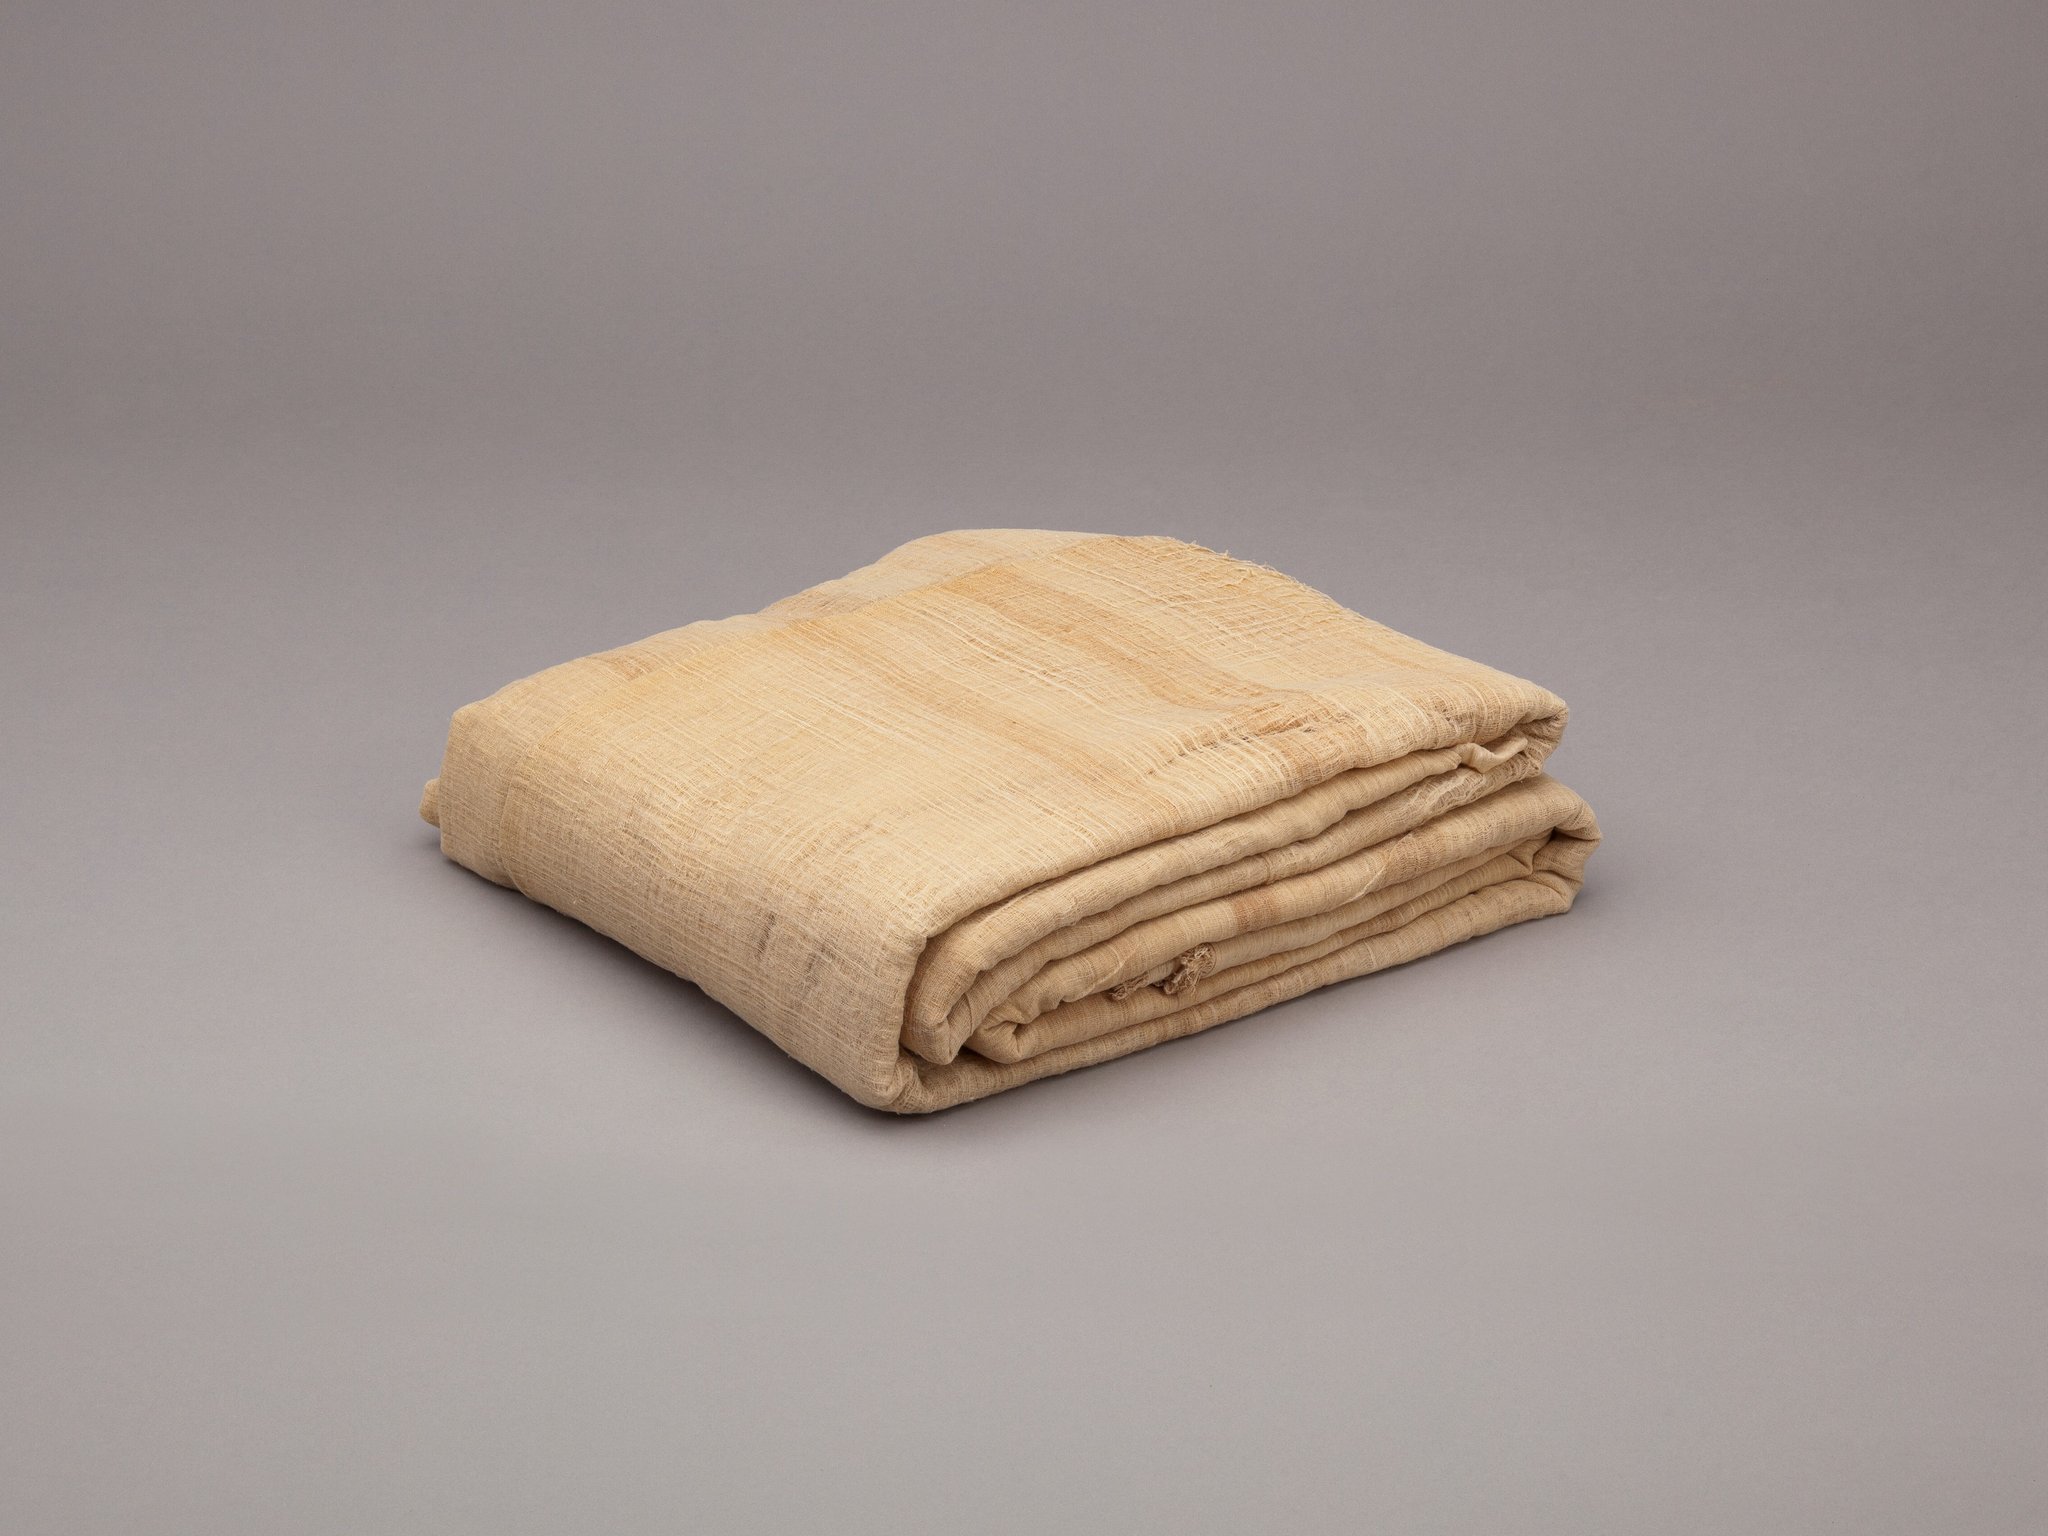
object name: linen mark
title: Sheet, linen mark, fine spin, irregular weave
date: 1492-1473 BCE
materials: linen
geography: egypt